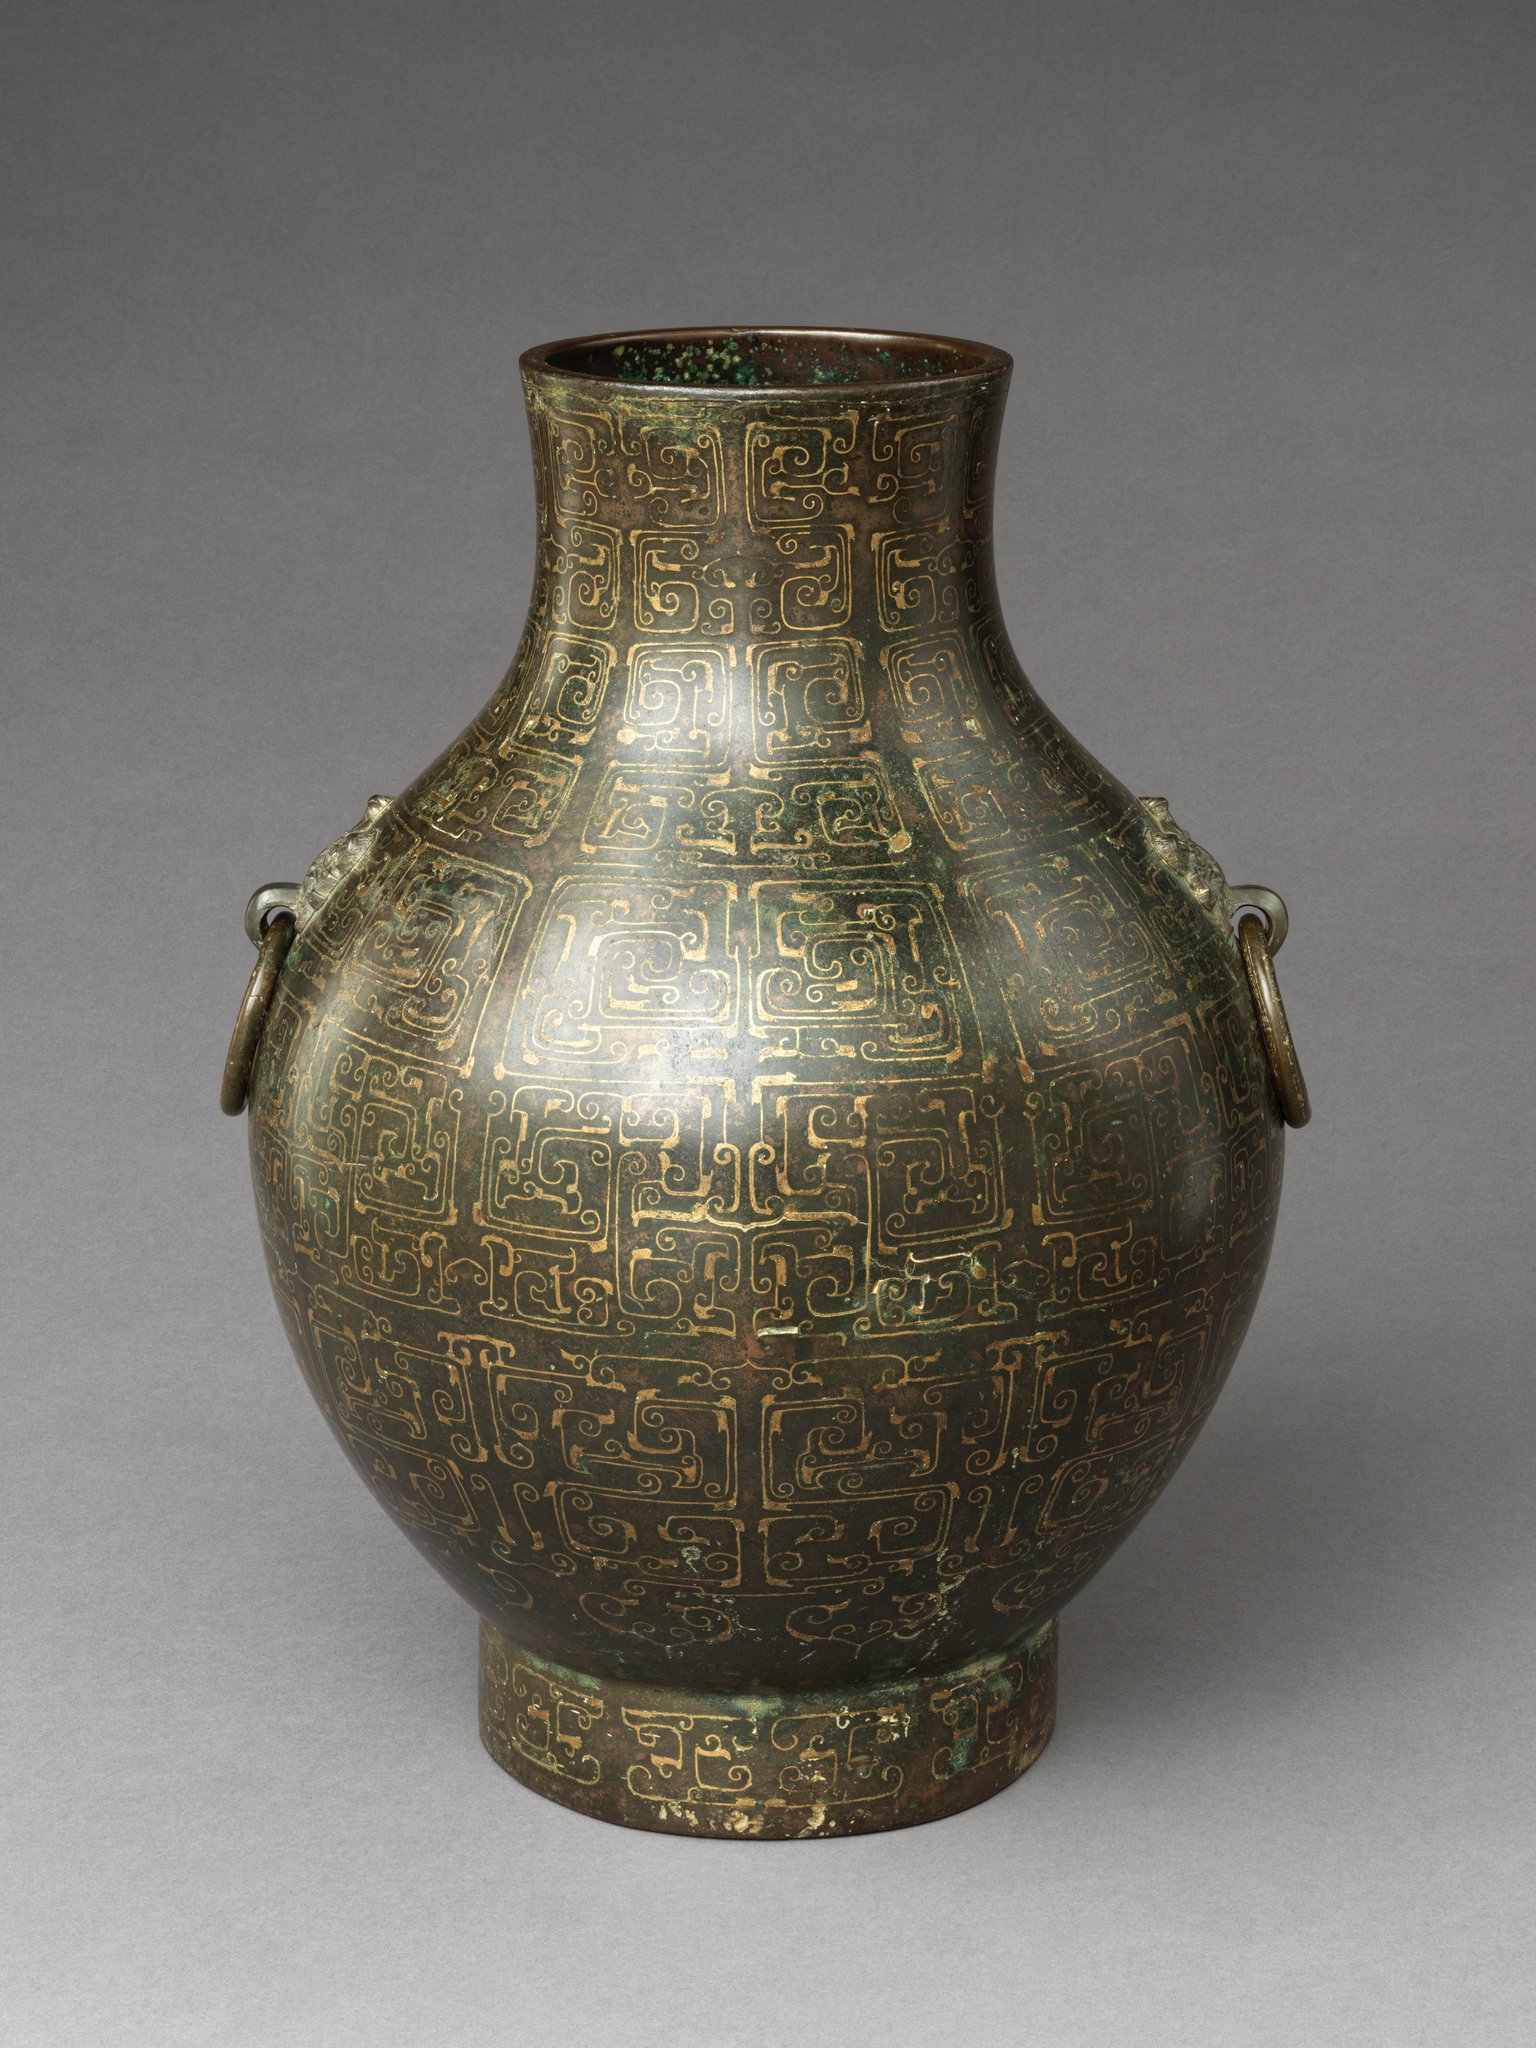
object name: wine container hu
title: Wine container (hu)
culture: chinese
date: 500-301 BCE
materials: bronze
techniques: inlay